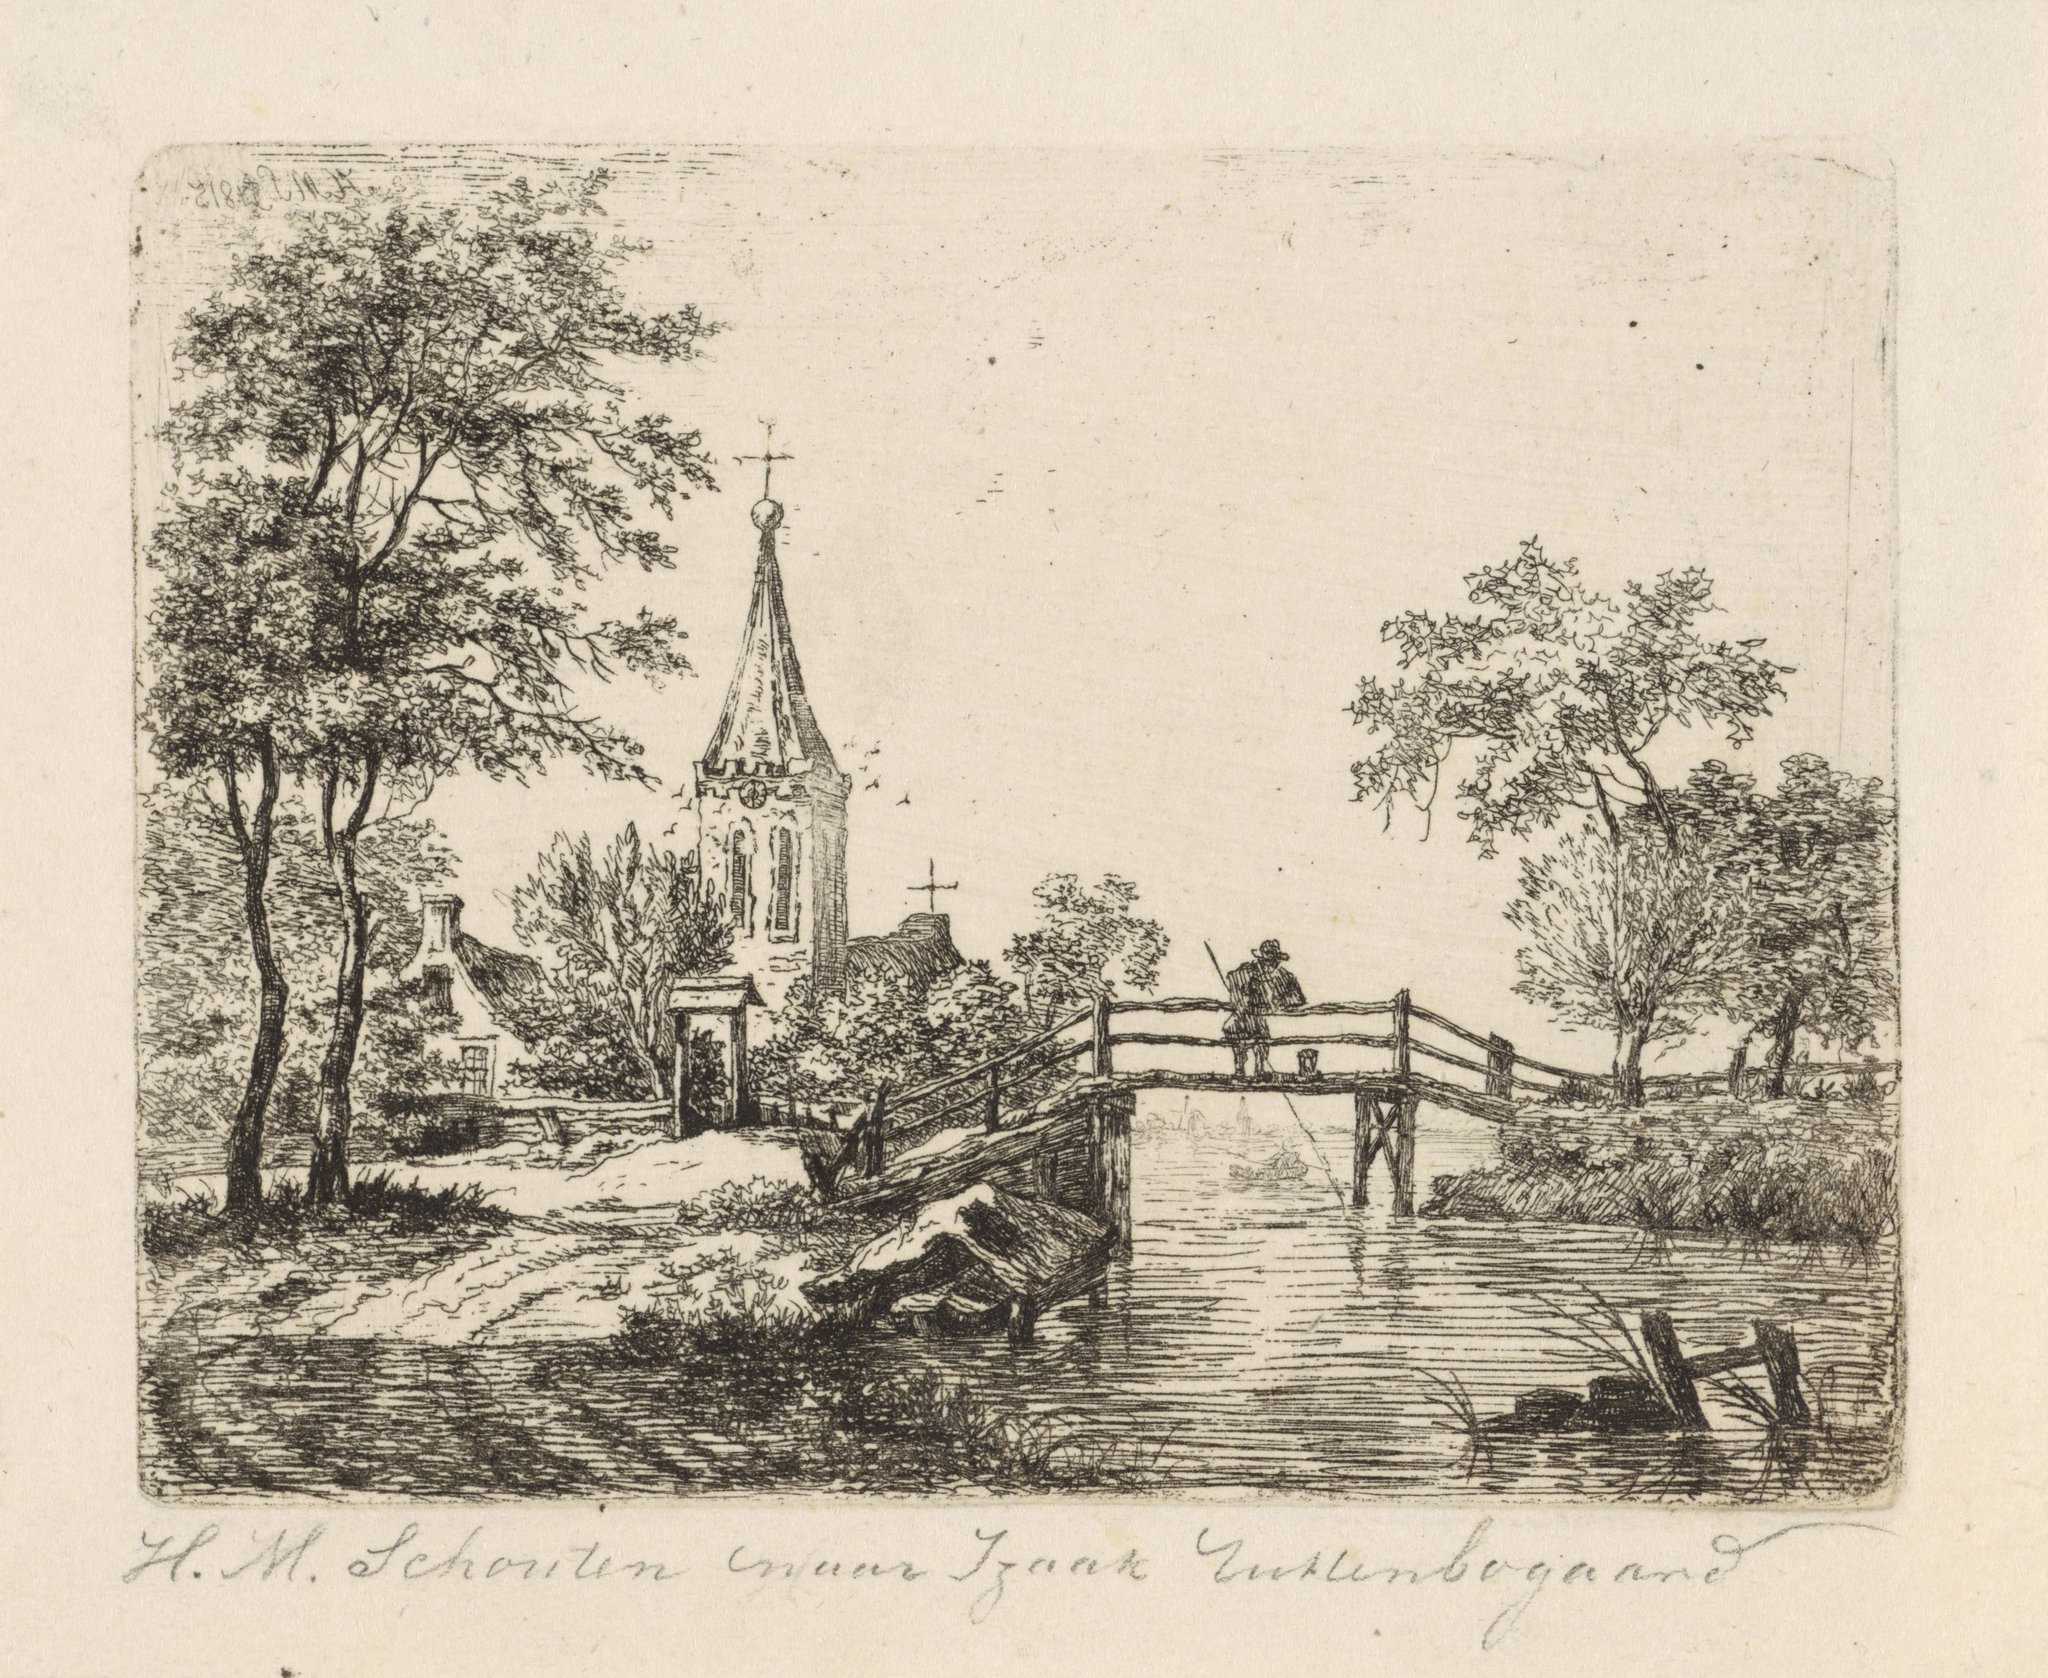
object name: print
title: Landschap met visser op een brug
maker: hendrik marcus schouten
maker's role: print maker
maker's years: 1791-1835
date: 1806-1835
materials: paper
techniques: etching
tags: river bank - hh - ideal landscapes, fisherman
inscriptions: collector's mark: Lugt 2228, inscription: ‘H.M. Schouten naar Izaak Uitenbogaard’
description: Een man staat op een bruggetje te vissen. Op de achtergrond een dorp met een kerk.